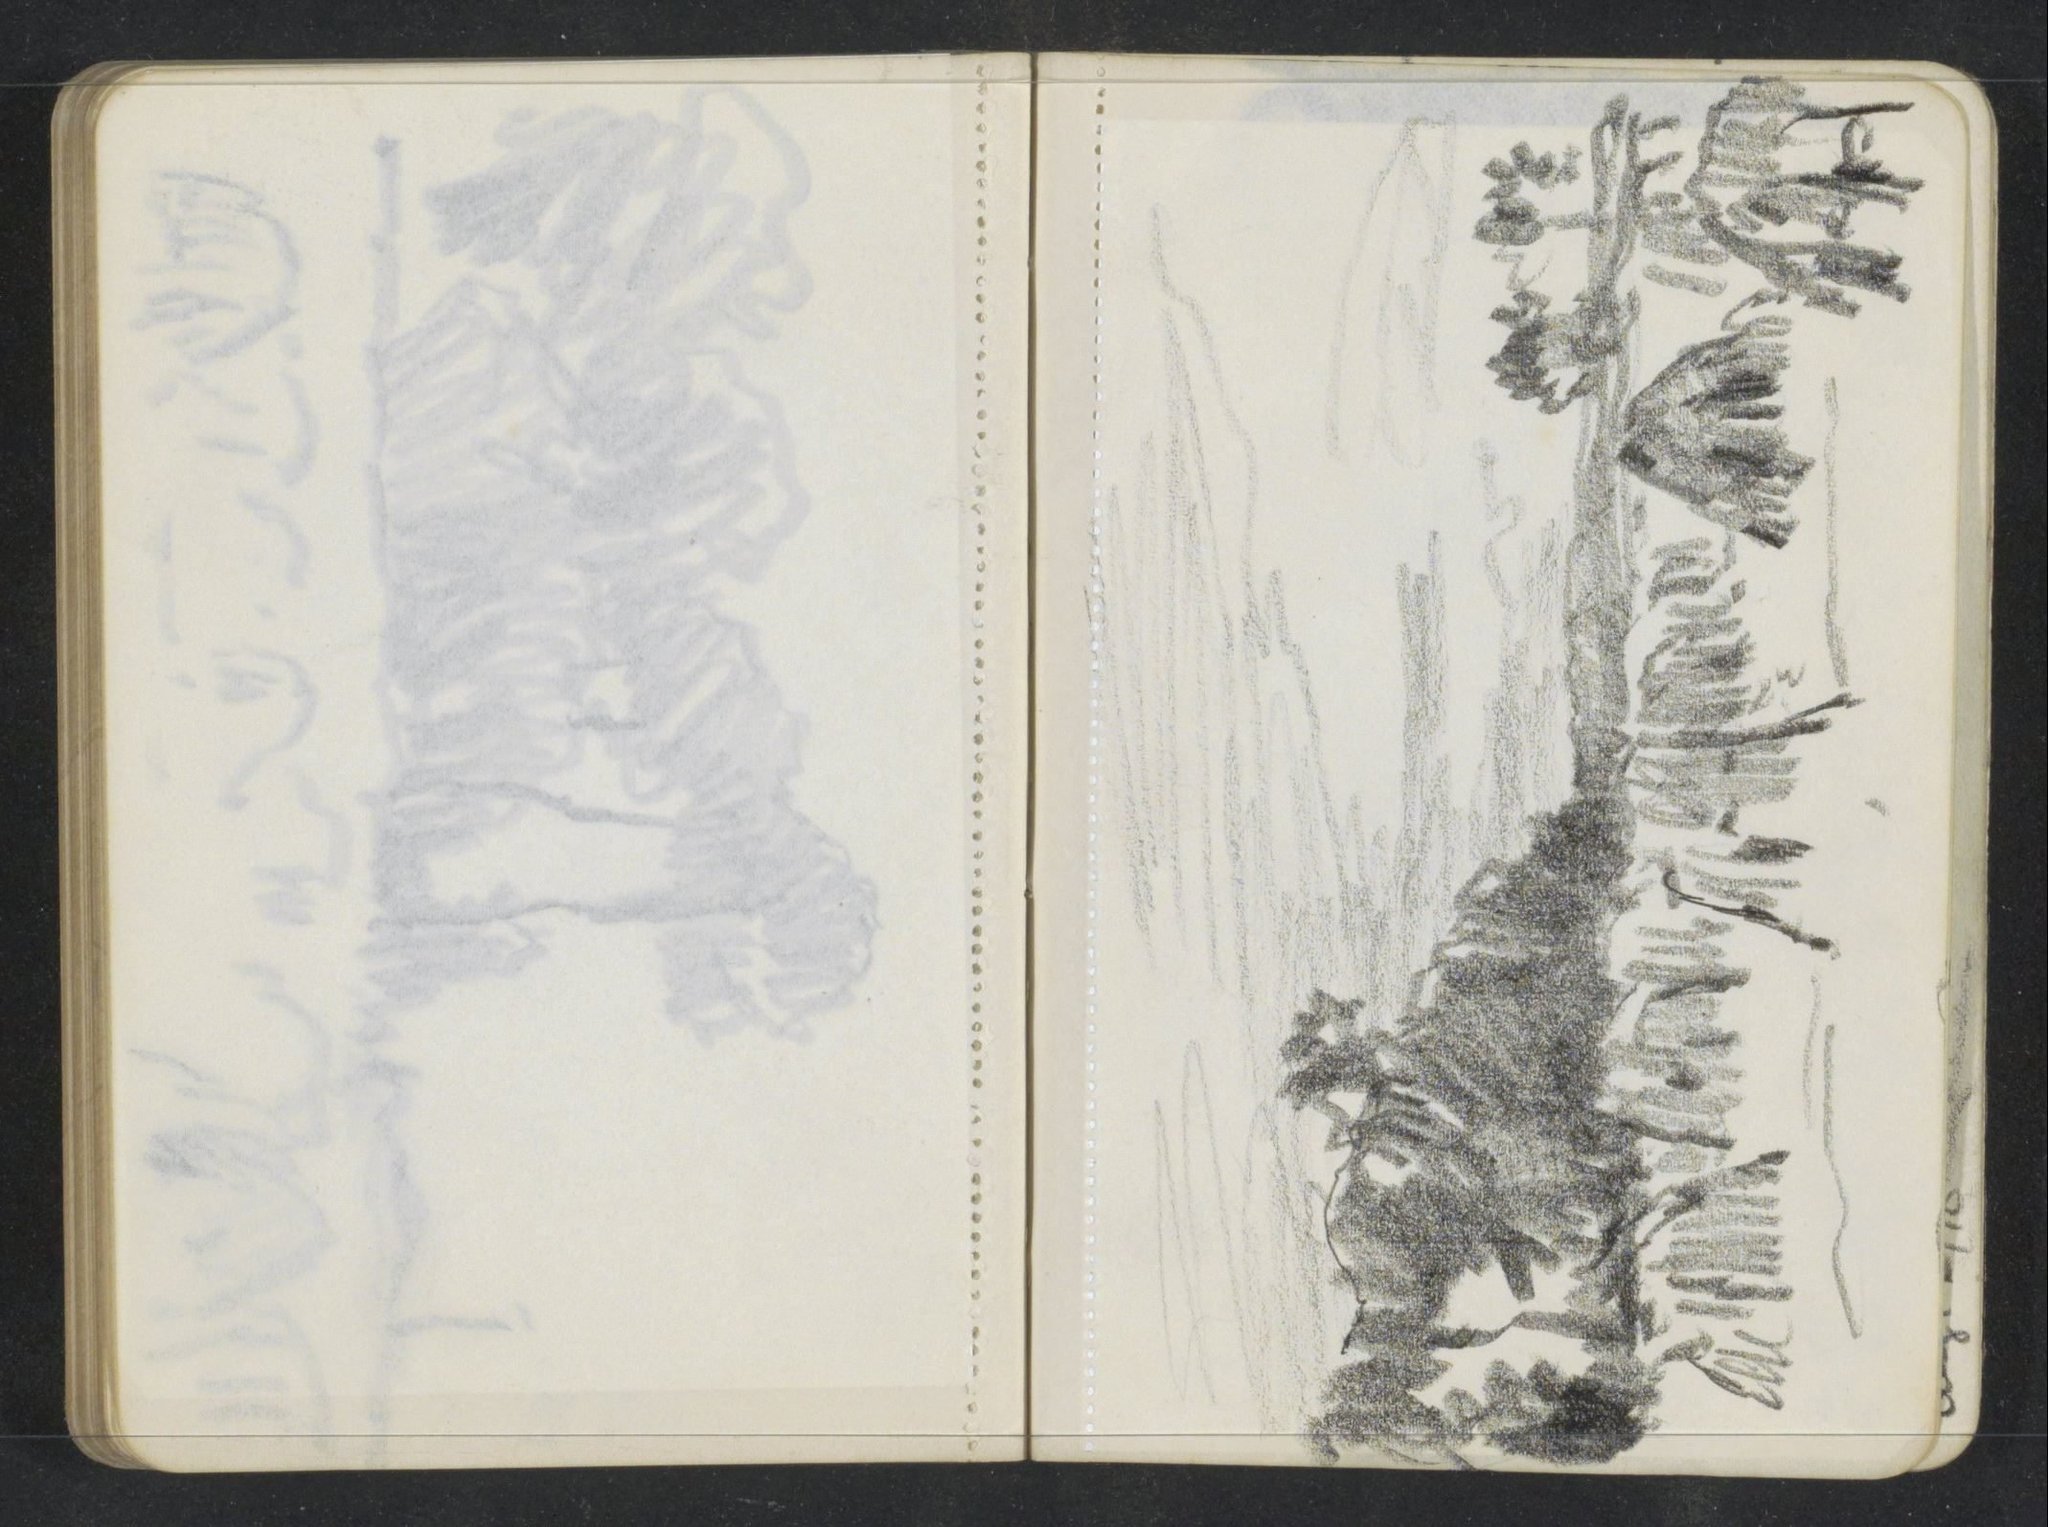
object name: sketchbook leaf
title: Hooioppers in een weiland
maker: alexander shilling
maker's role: draughtsman, print maker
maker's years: 1859-1937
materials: paper, pencil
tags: hay-cock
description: Blad 68 recto uit een schetsboek met 91 bladen.